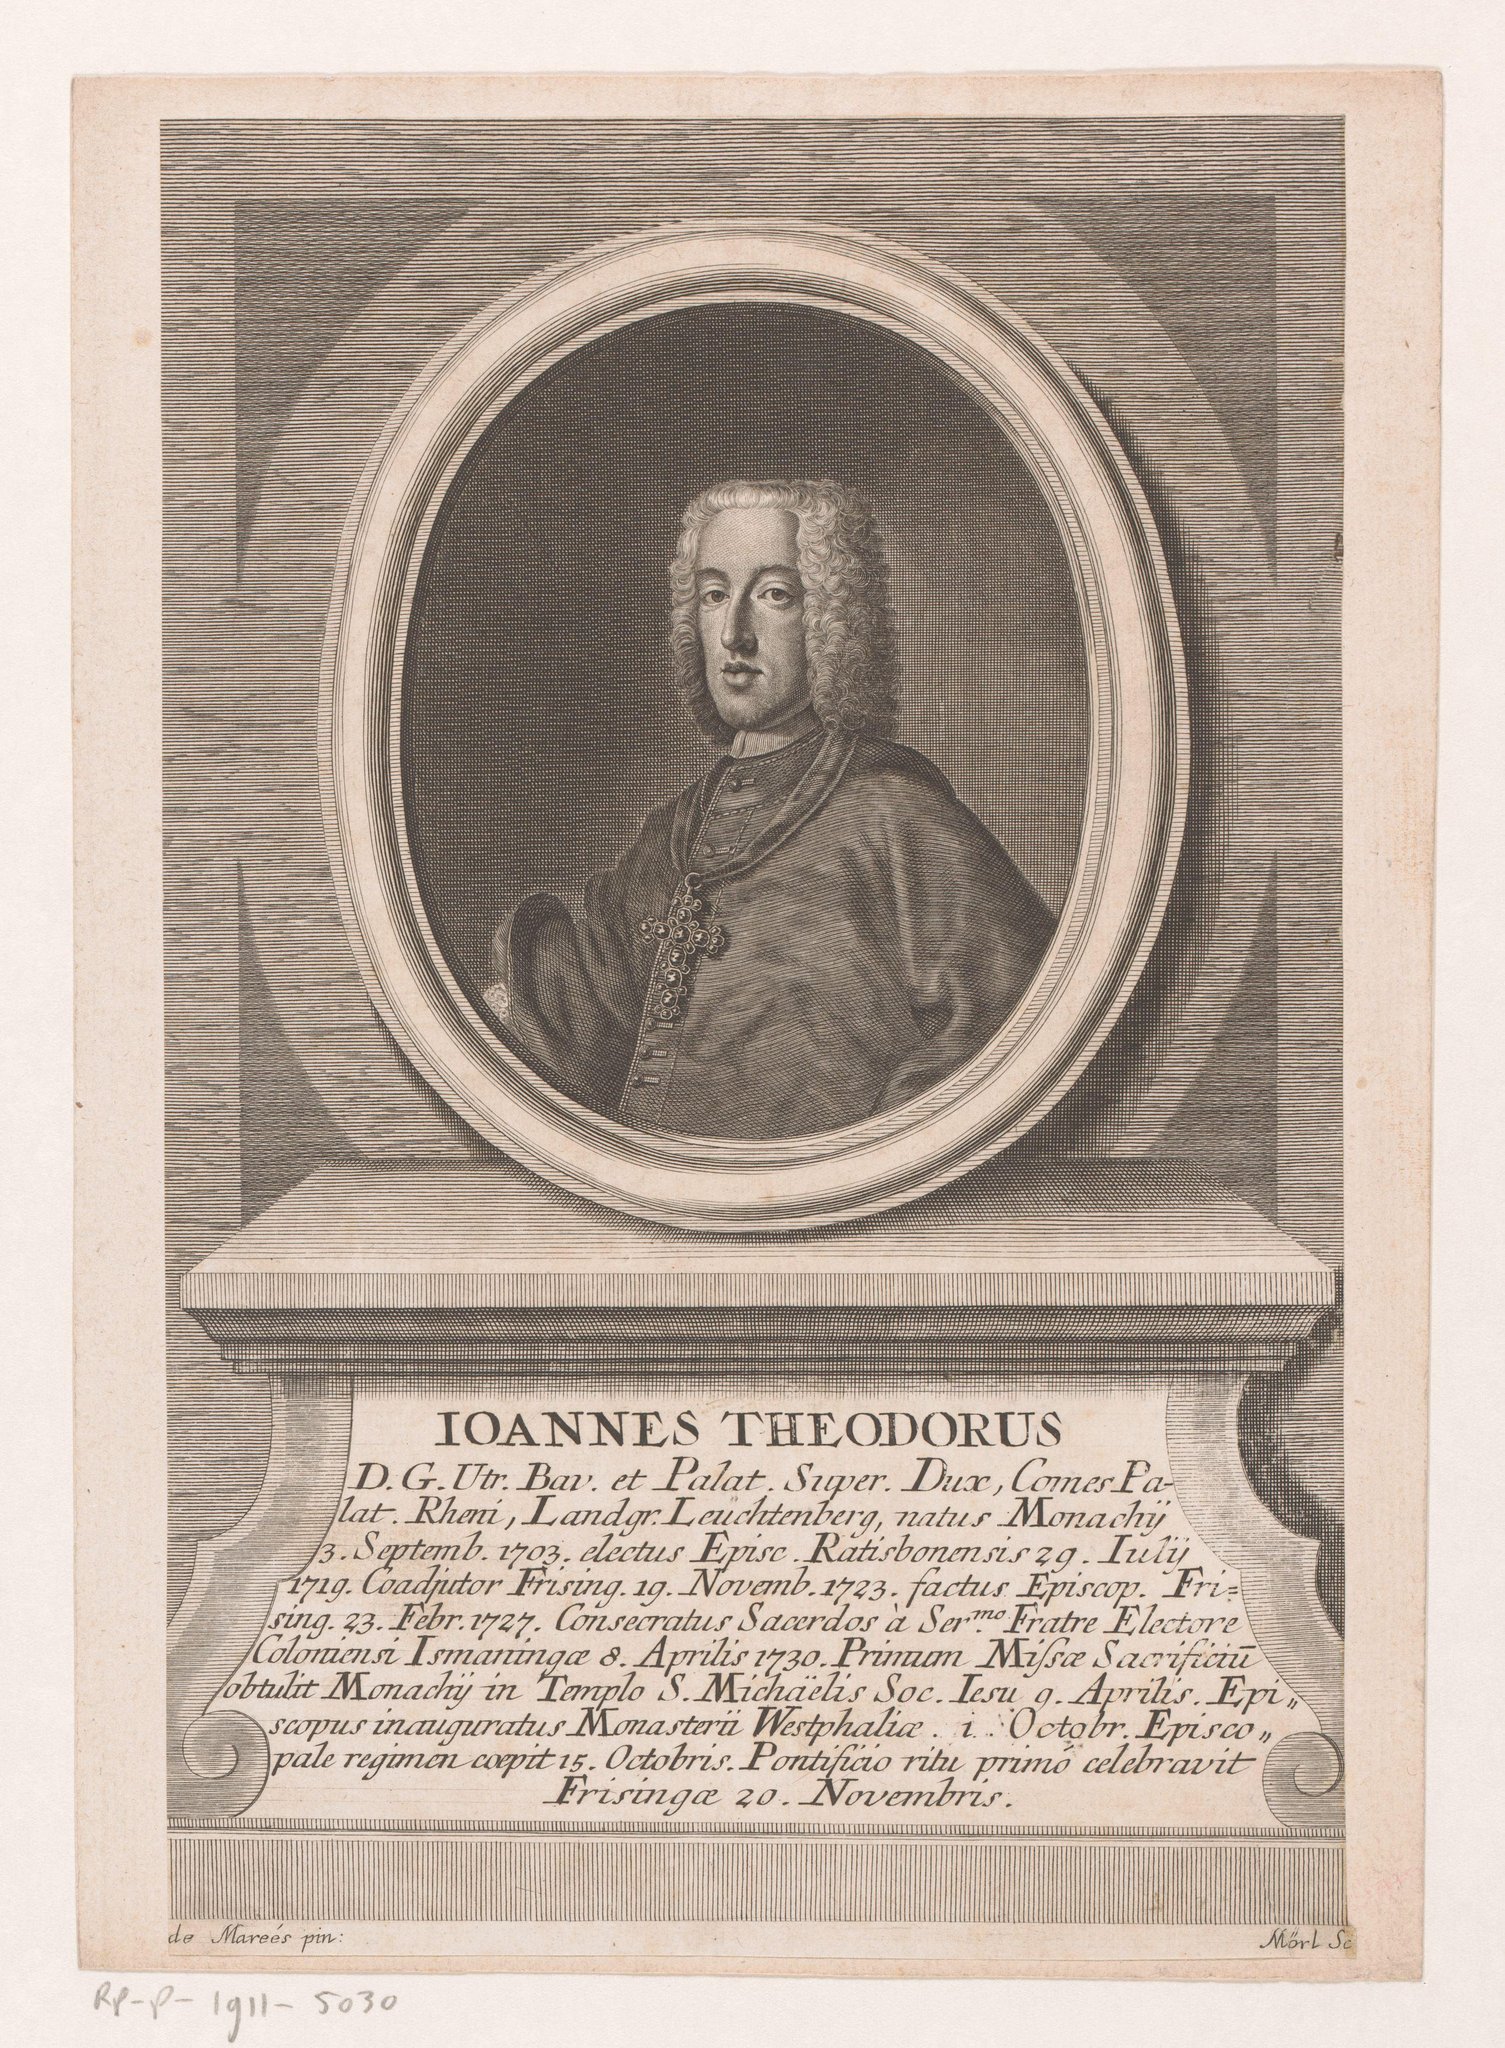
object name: print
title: Portret Johann Theodor von Bayern, bisschop van Regensburg en Luik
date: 1723-1735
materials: paper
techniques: engraving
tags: historical persons, crucifix ~ personal devotion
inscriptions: collector's mark: Lugt 2228